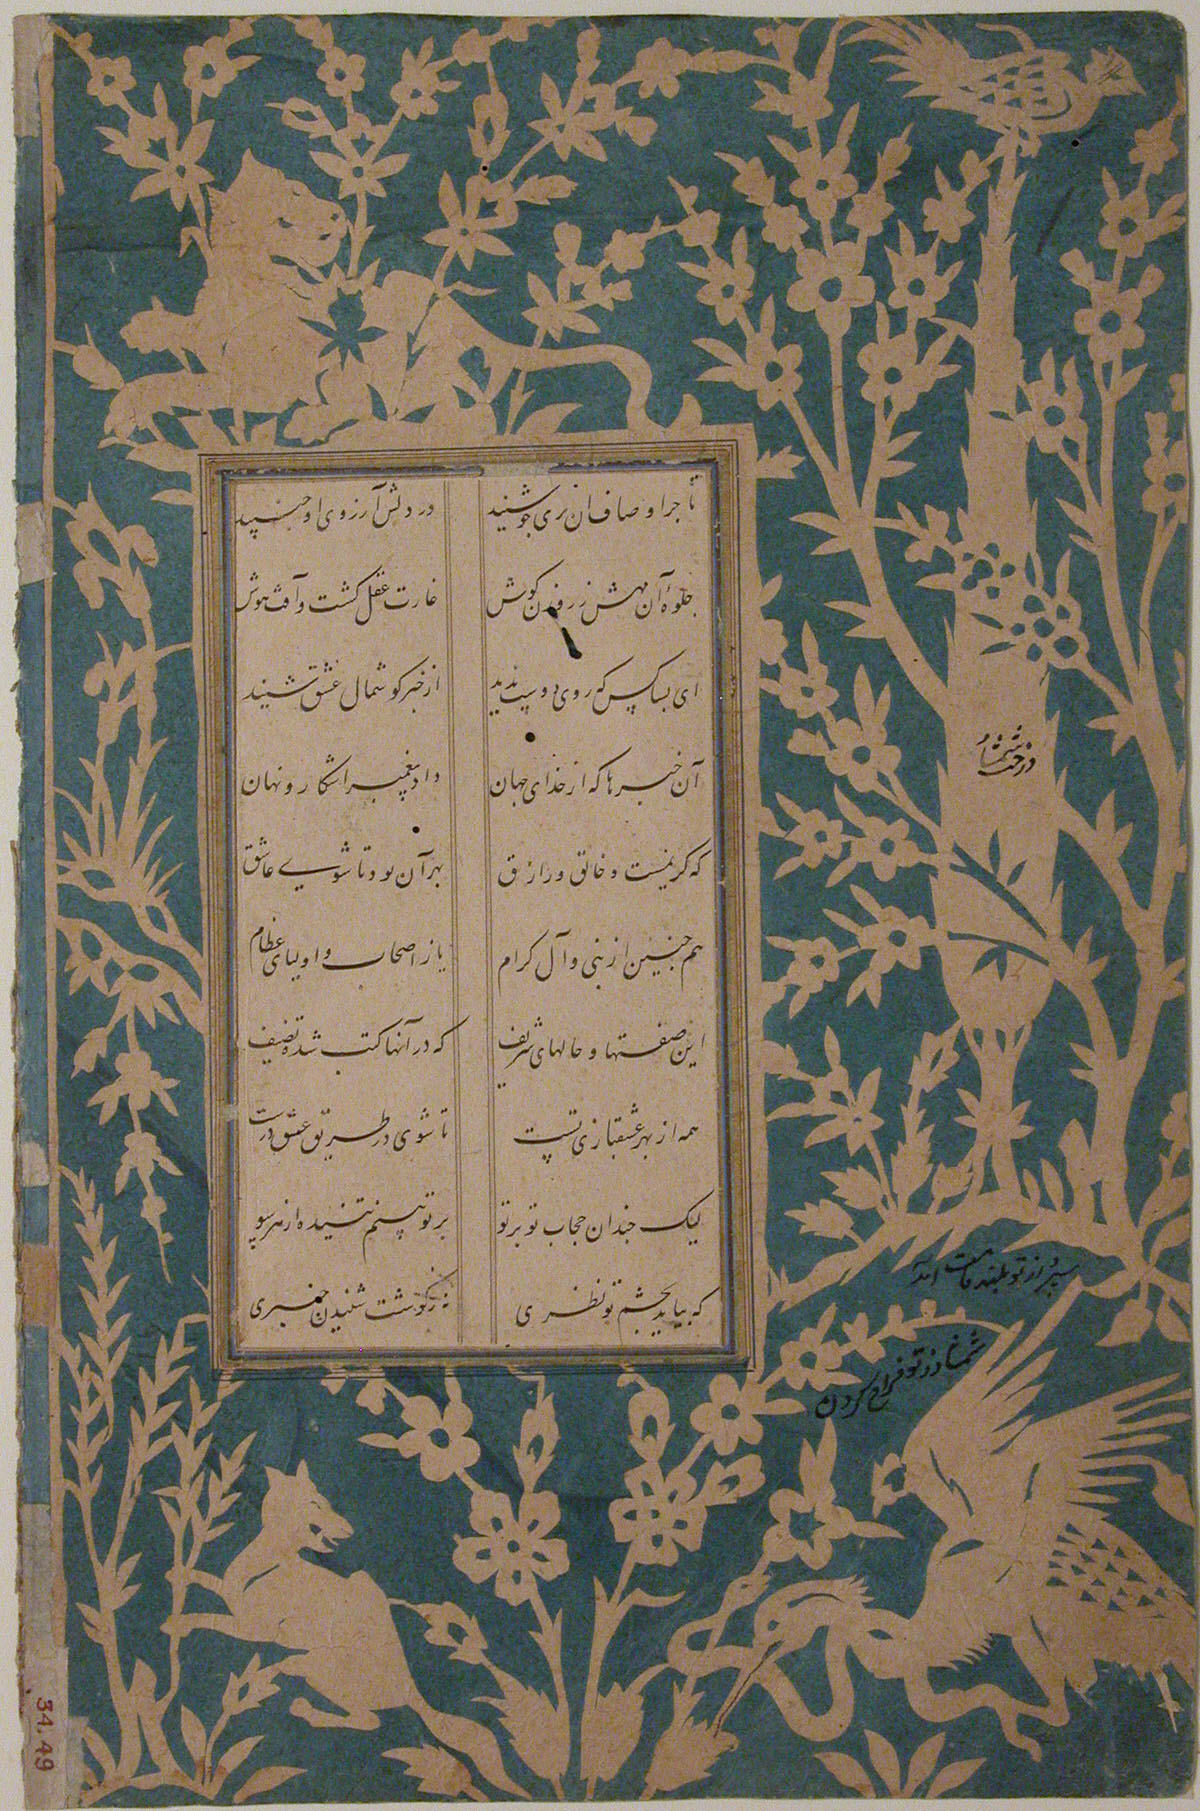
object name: non illustrated album leaf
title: Leaf of Calligraphy from Poems by Sa'di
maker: sa'di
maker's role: author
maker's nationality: iranian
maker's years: 1213-1291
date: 1501-1600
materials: gold, ink, paper, watercolor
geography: iran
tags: poetry,flowers